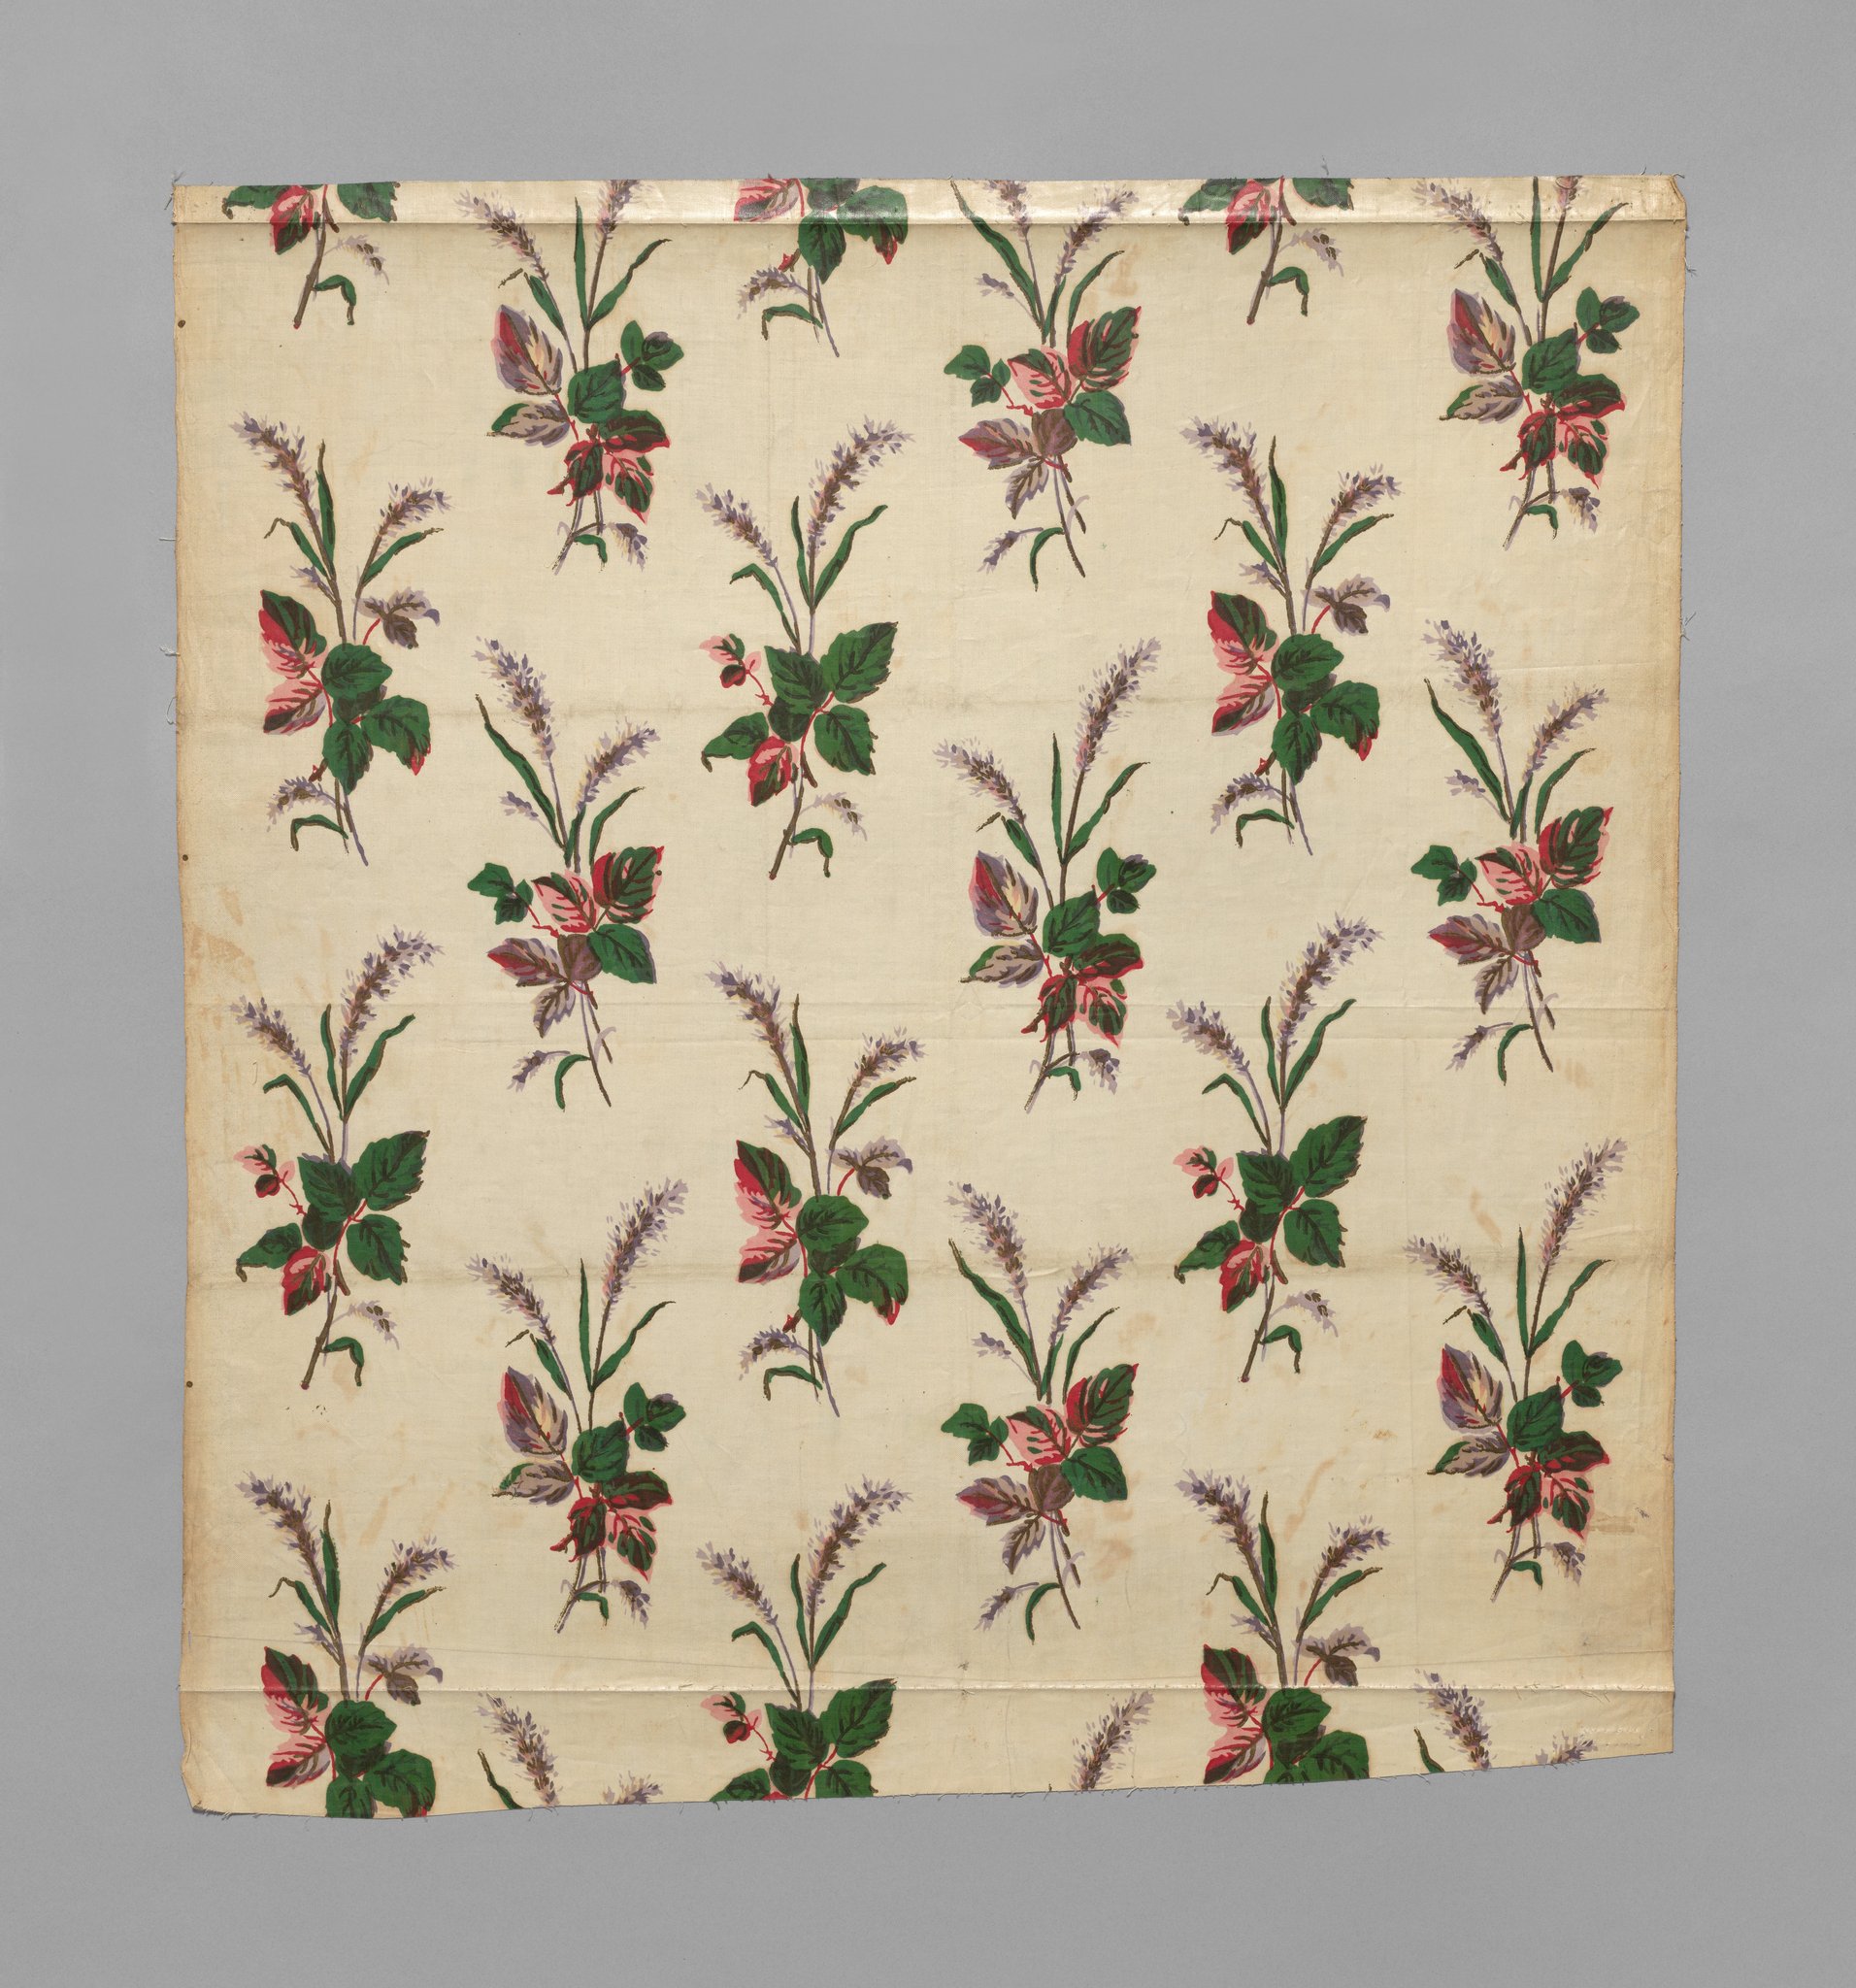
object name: piece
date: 1851-1872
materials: cotton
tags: flowers